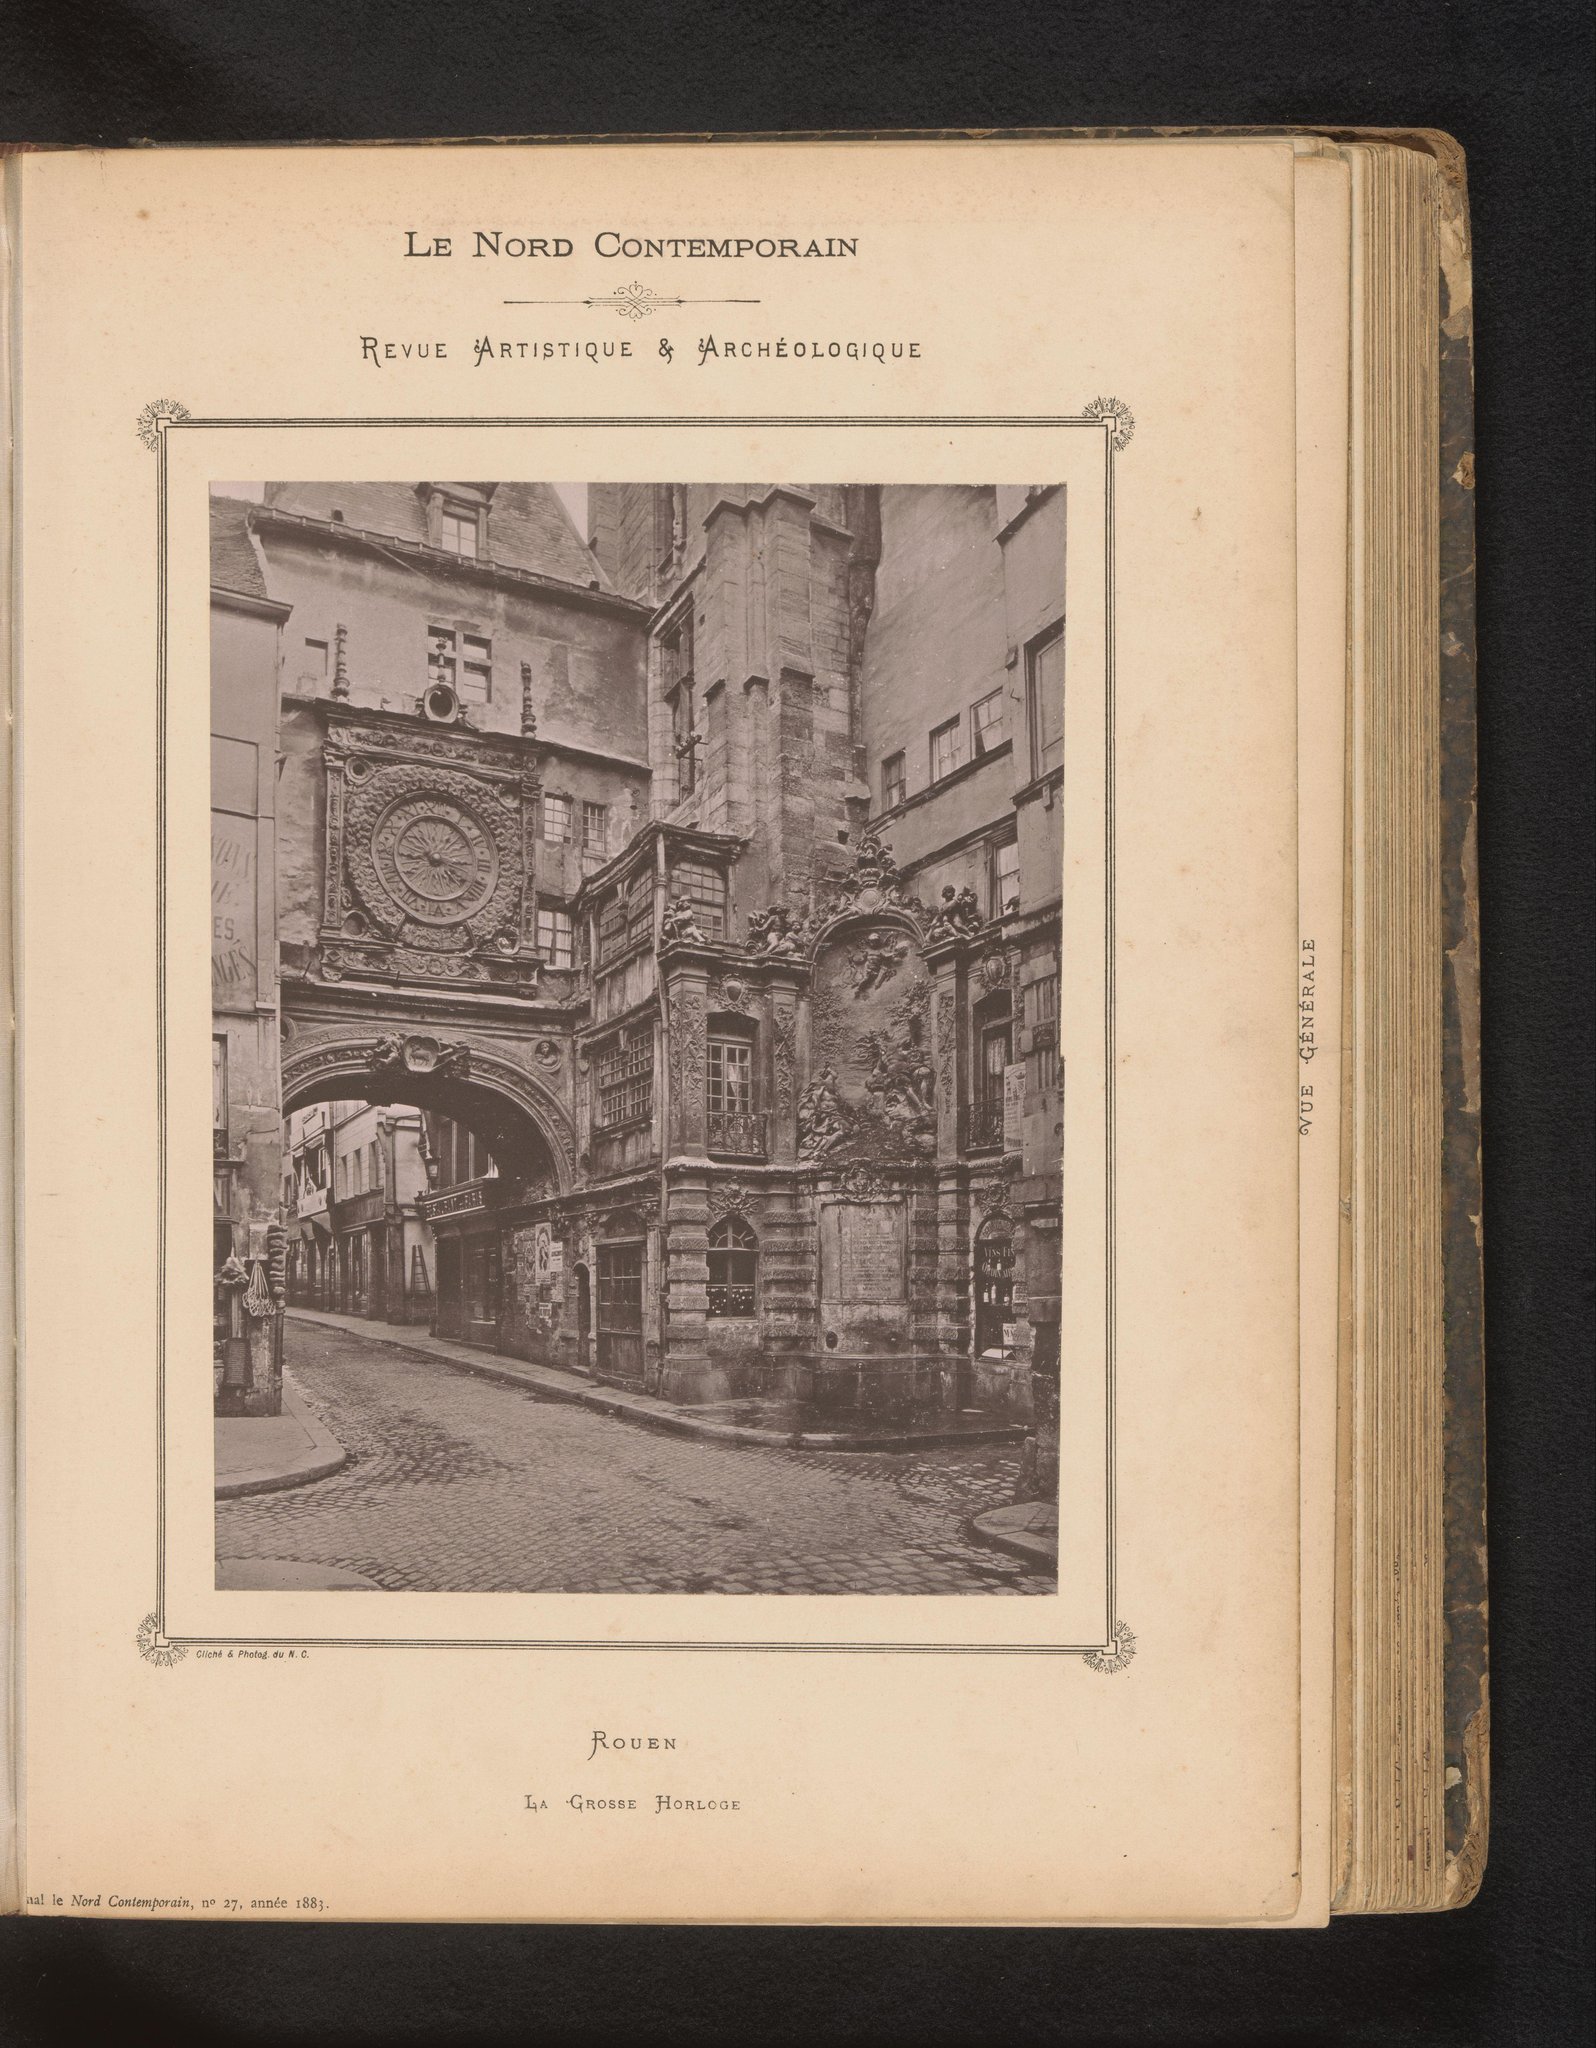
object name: page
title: Rouen, La Grosse Horloge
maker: n.c.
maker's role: fotograaf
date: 1878-1883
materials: paper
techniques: photograph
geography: rouen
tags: tower, clock tower ~ monumental adornment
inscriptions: inscription: ‘Le Nord Contemporain/ Revue Artistique & Archéologique’, inscription: ‘[Jour]nal le Nord Contemporain, No 27, année 1883.’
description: Prent op derde ongenummerde pagina na pagina 48.